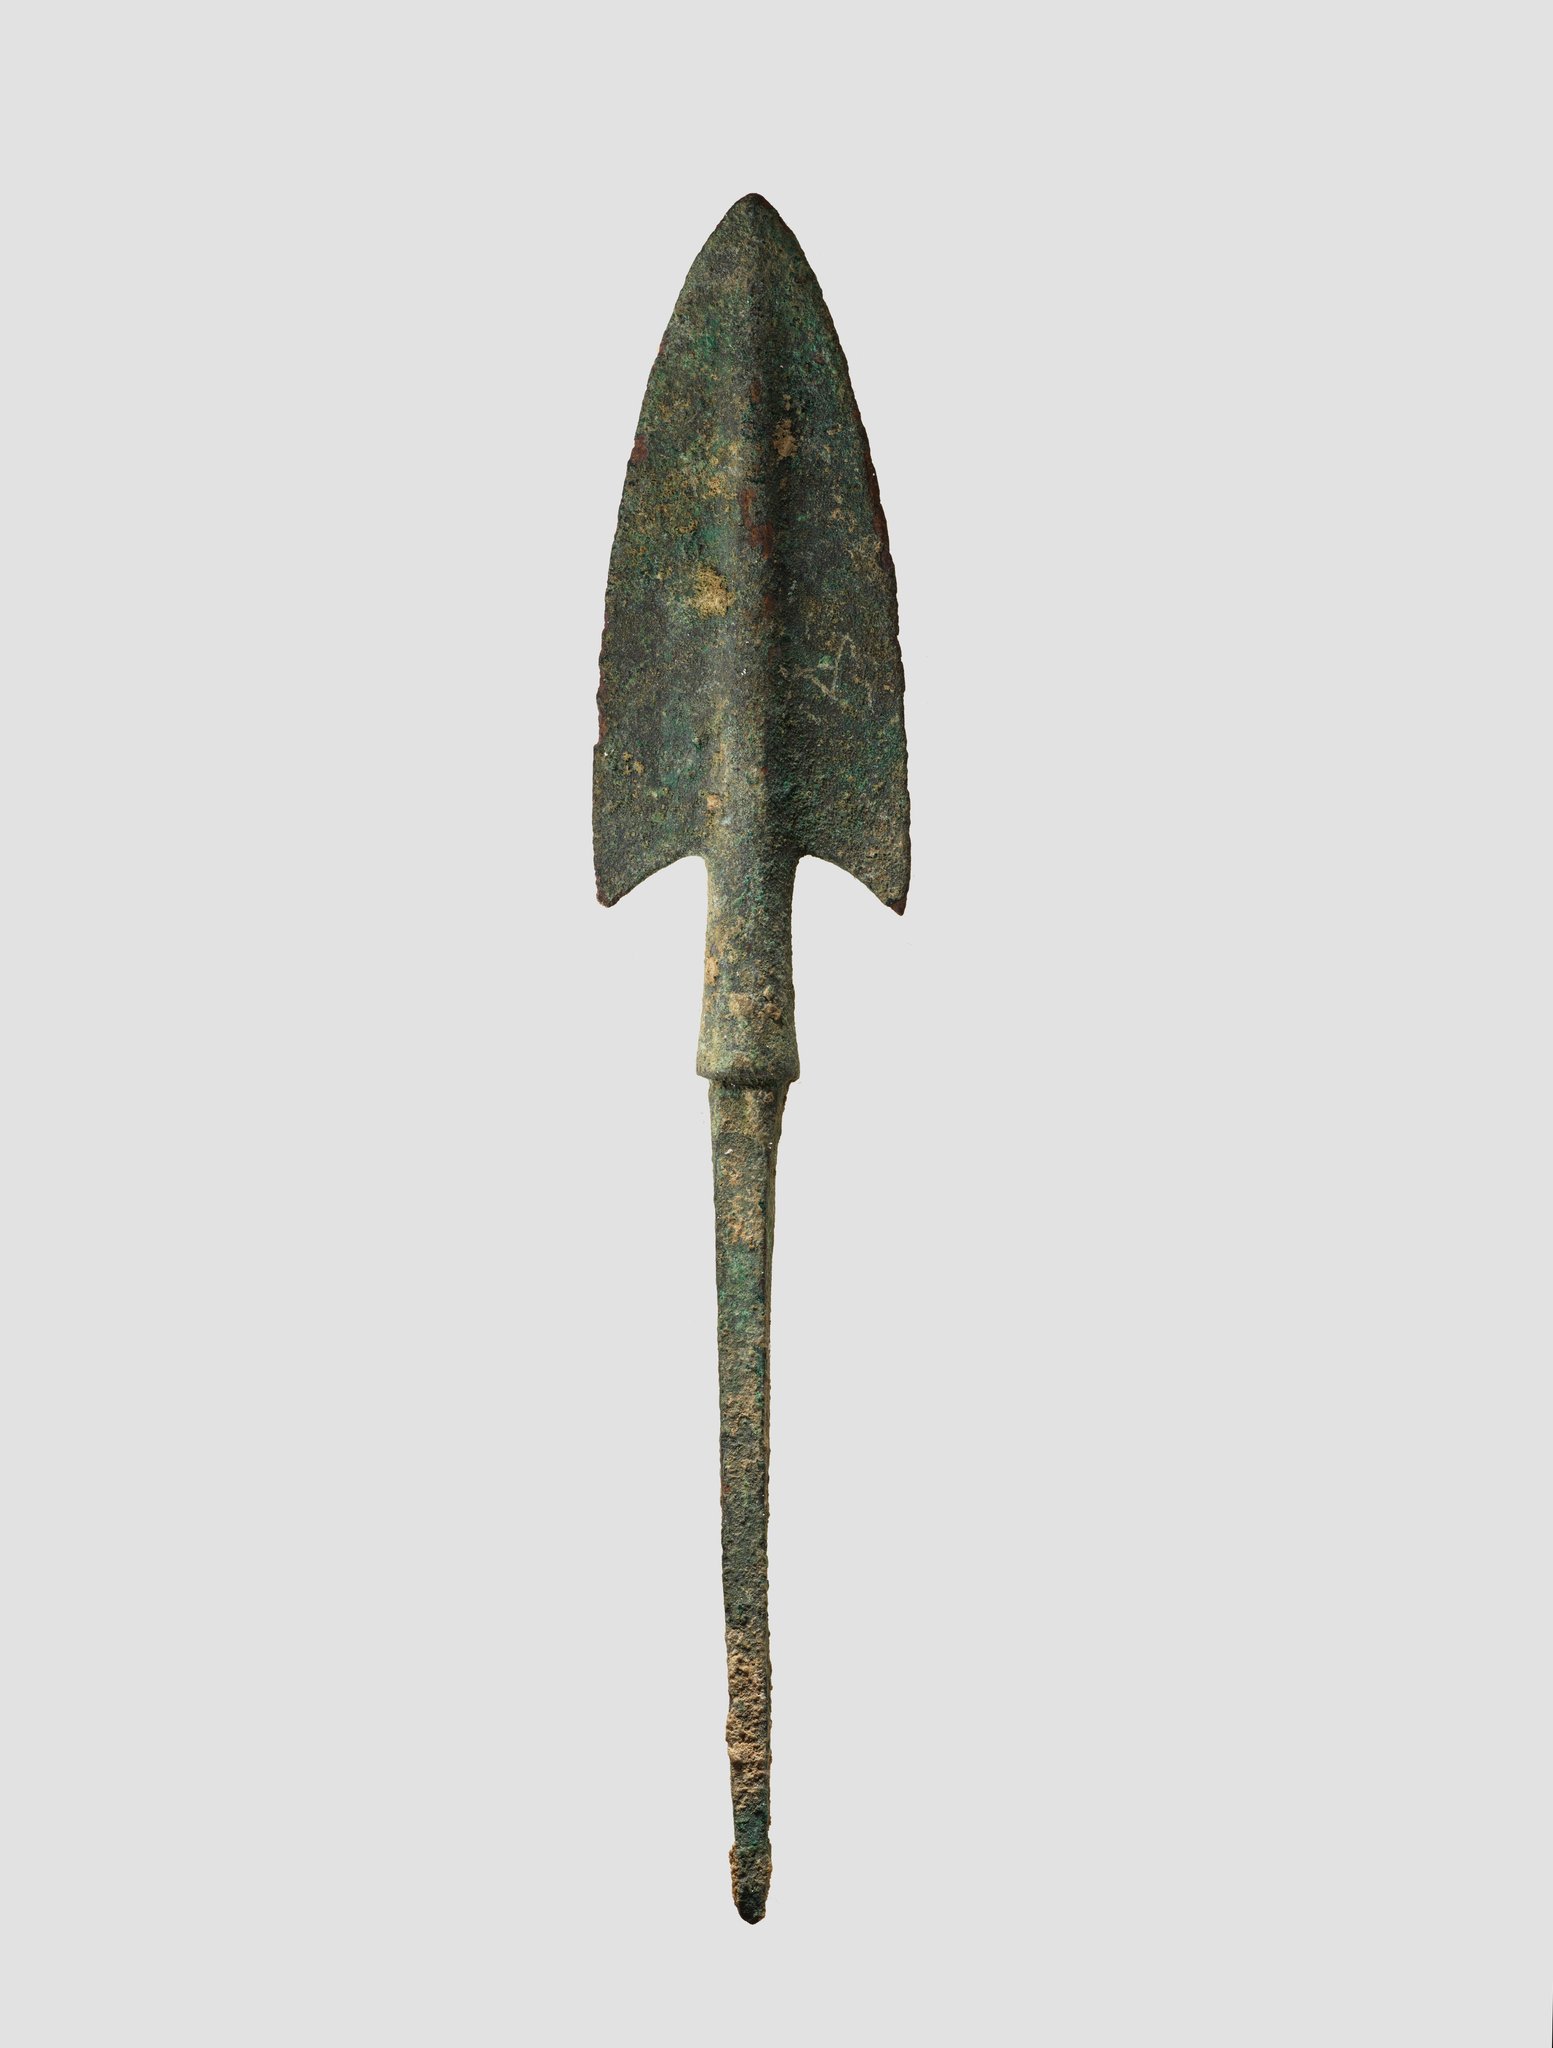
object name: arrowhead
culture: iranian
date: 2000-1 BCE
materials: bronze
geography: iran